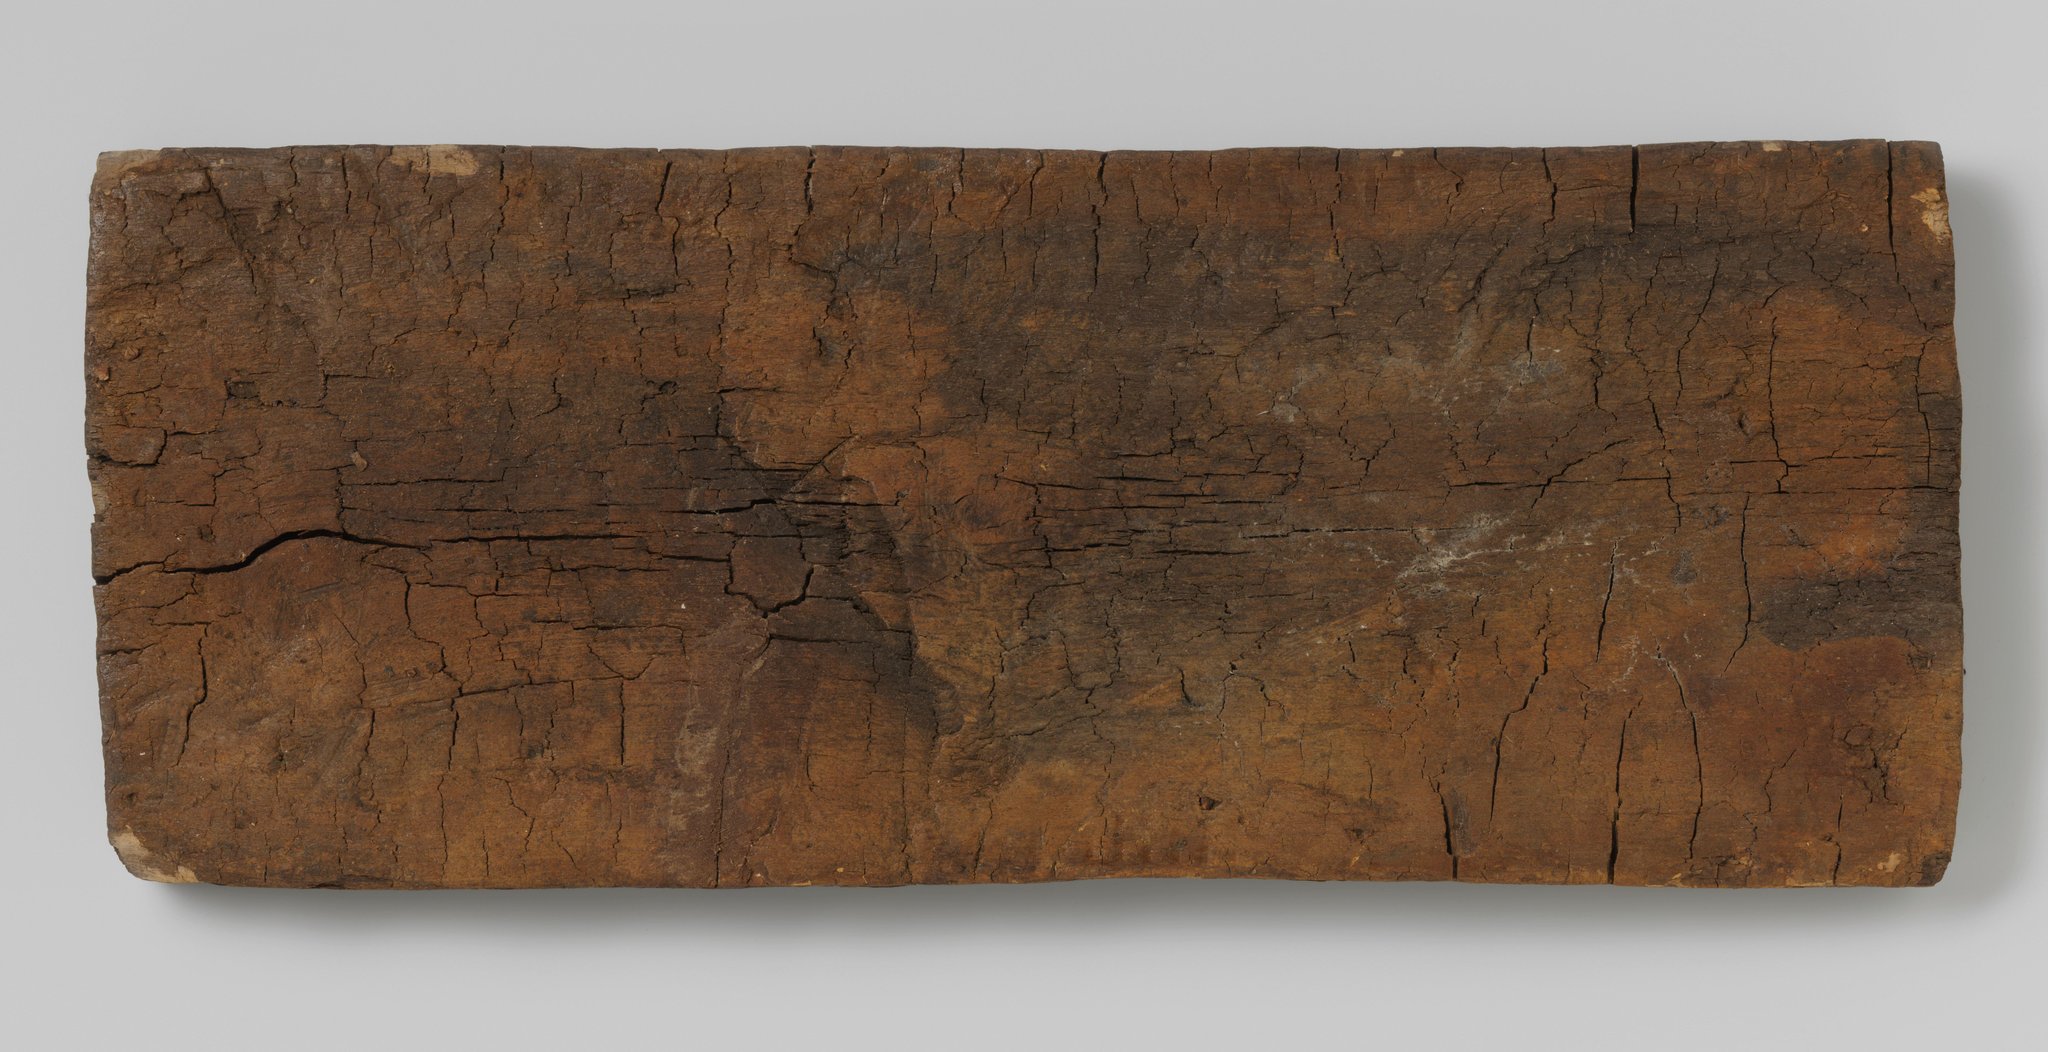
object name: fragment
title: Houten fragment van de VOC-werf Oostenburg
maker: Anonymous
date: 1600-1699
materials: wood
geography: netherlands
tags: amsterdam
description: Fragment van de basis van een van de scheepshellingen van de VOC-werf Oostenburg. In het hout zijn lijnen gekrast.